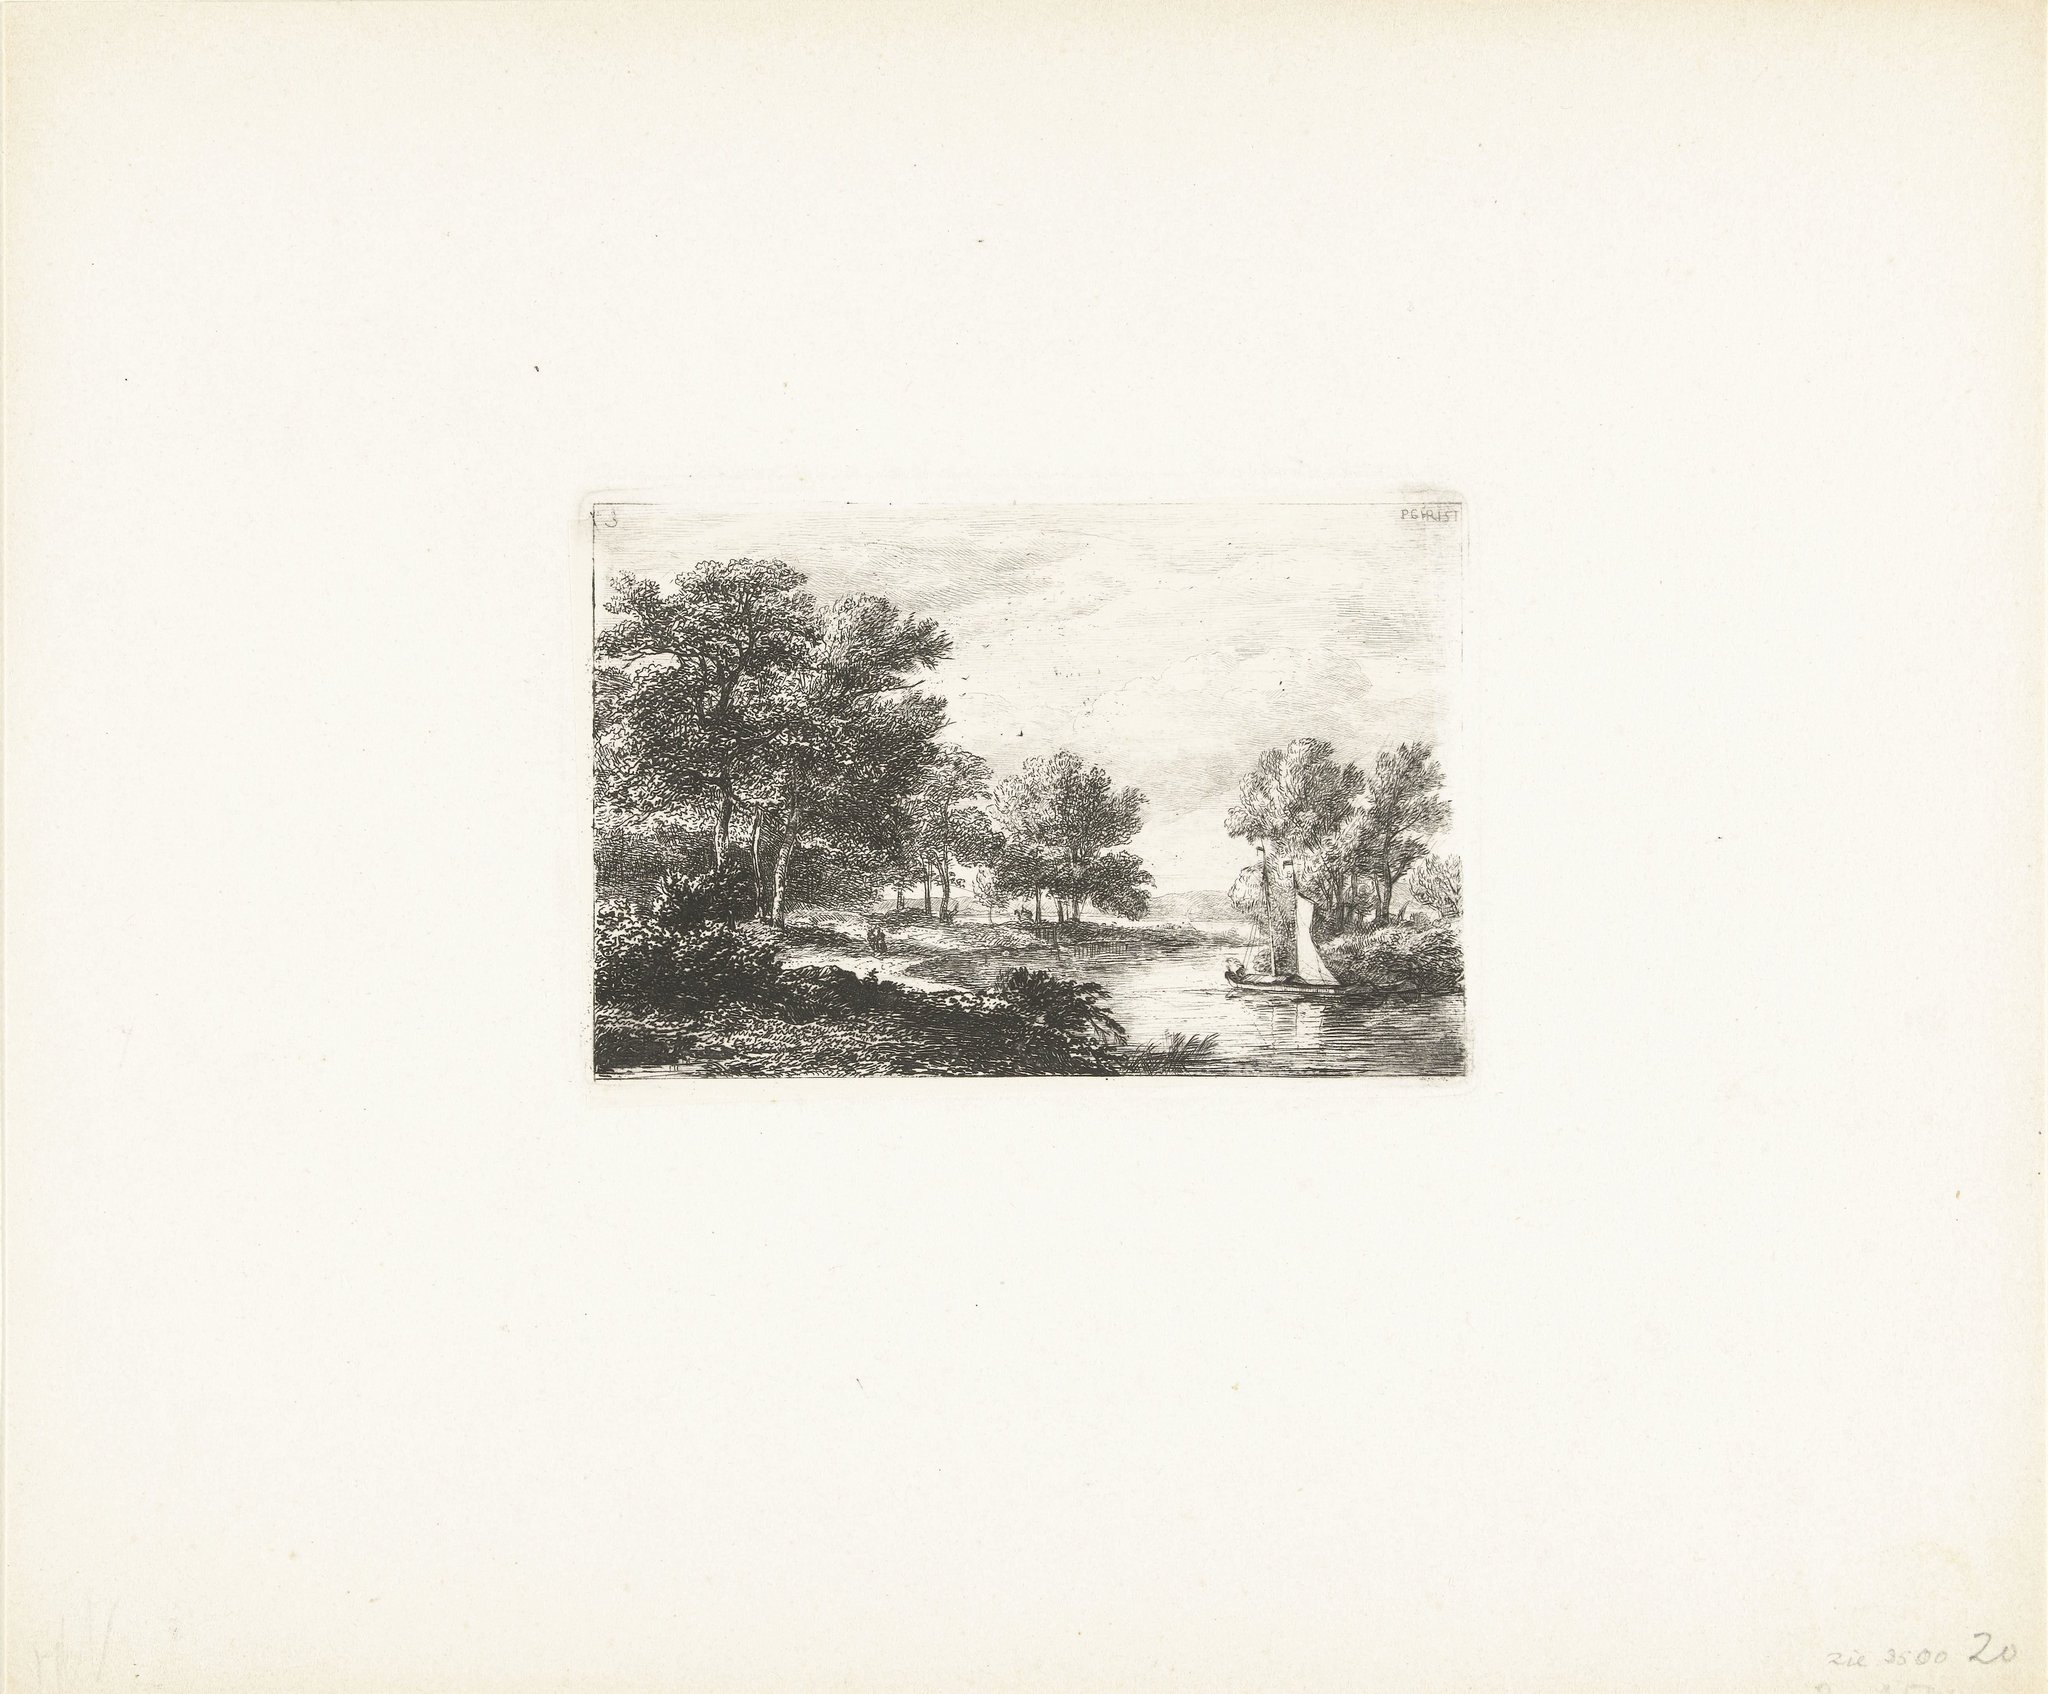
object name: print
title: Rivierlandschap met zeilschip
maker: pieter casper christ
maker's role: draughtsman, print maker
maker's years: 1822-1888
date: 1860-1870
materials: paper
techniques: etching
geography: arnhem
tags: landscapes with waters, waterscapes, seascapes (in the temperate zone) (+ landscape with figures, staffage)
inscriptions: collector's mark: Lugt 2228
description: Uit inventarisboek: Op den omslag: Zestal etsen door P. Christ. Arnhem H.B. Breyer. Prijs 2,50.